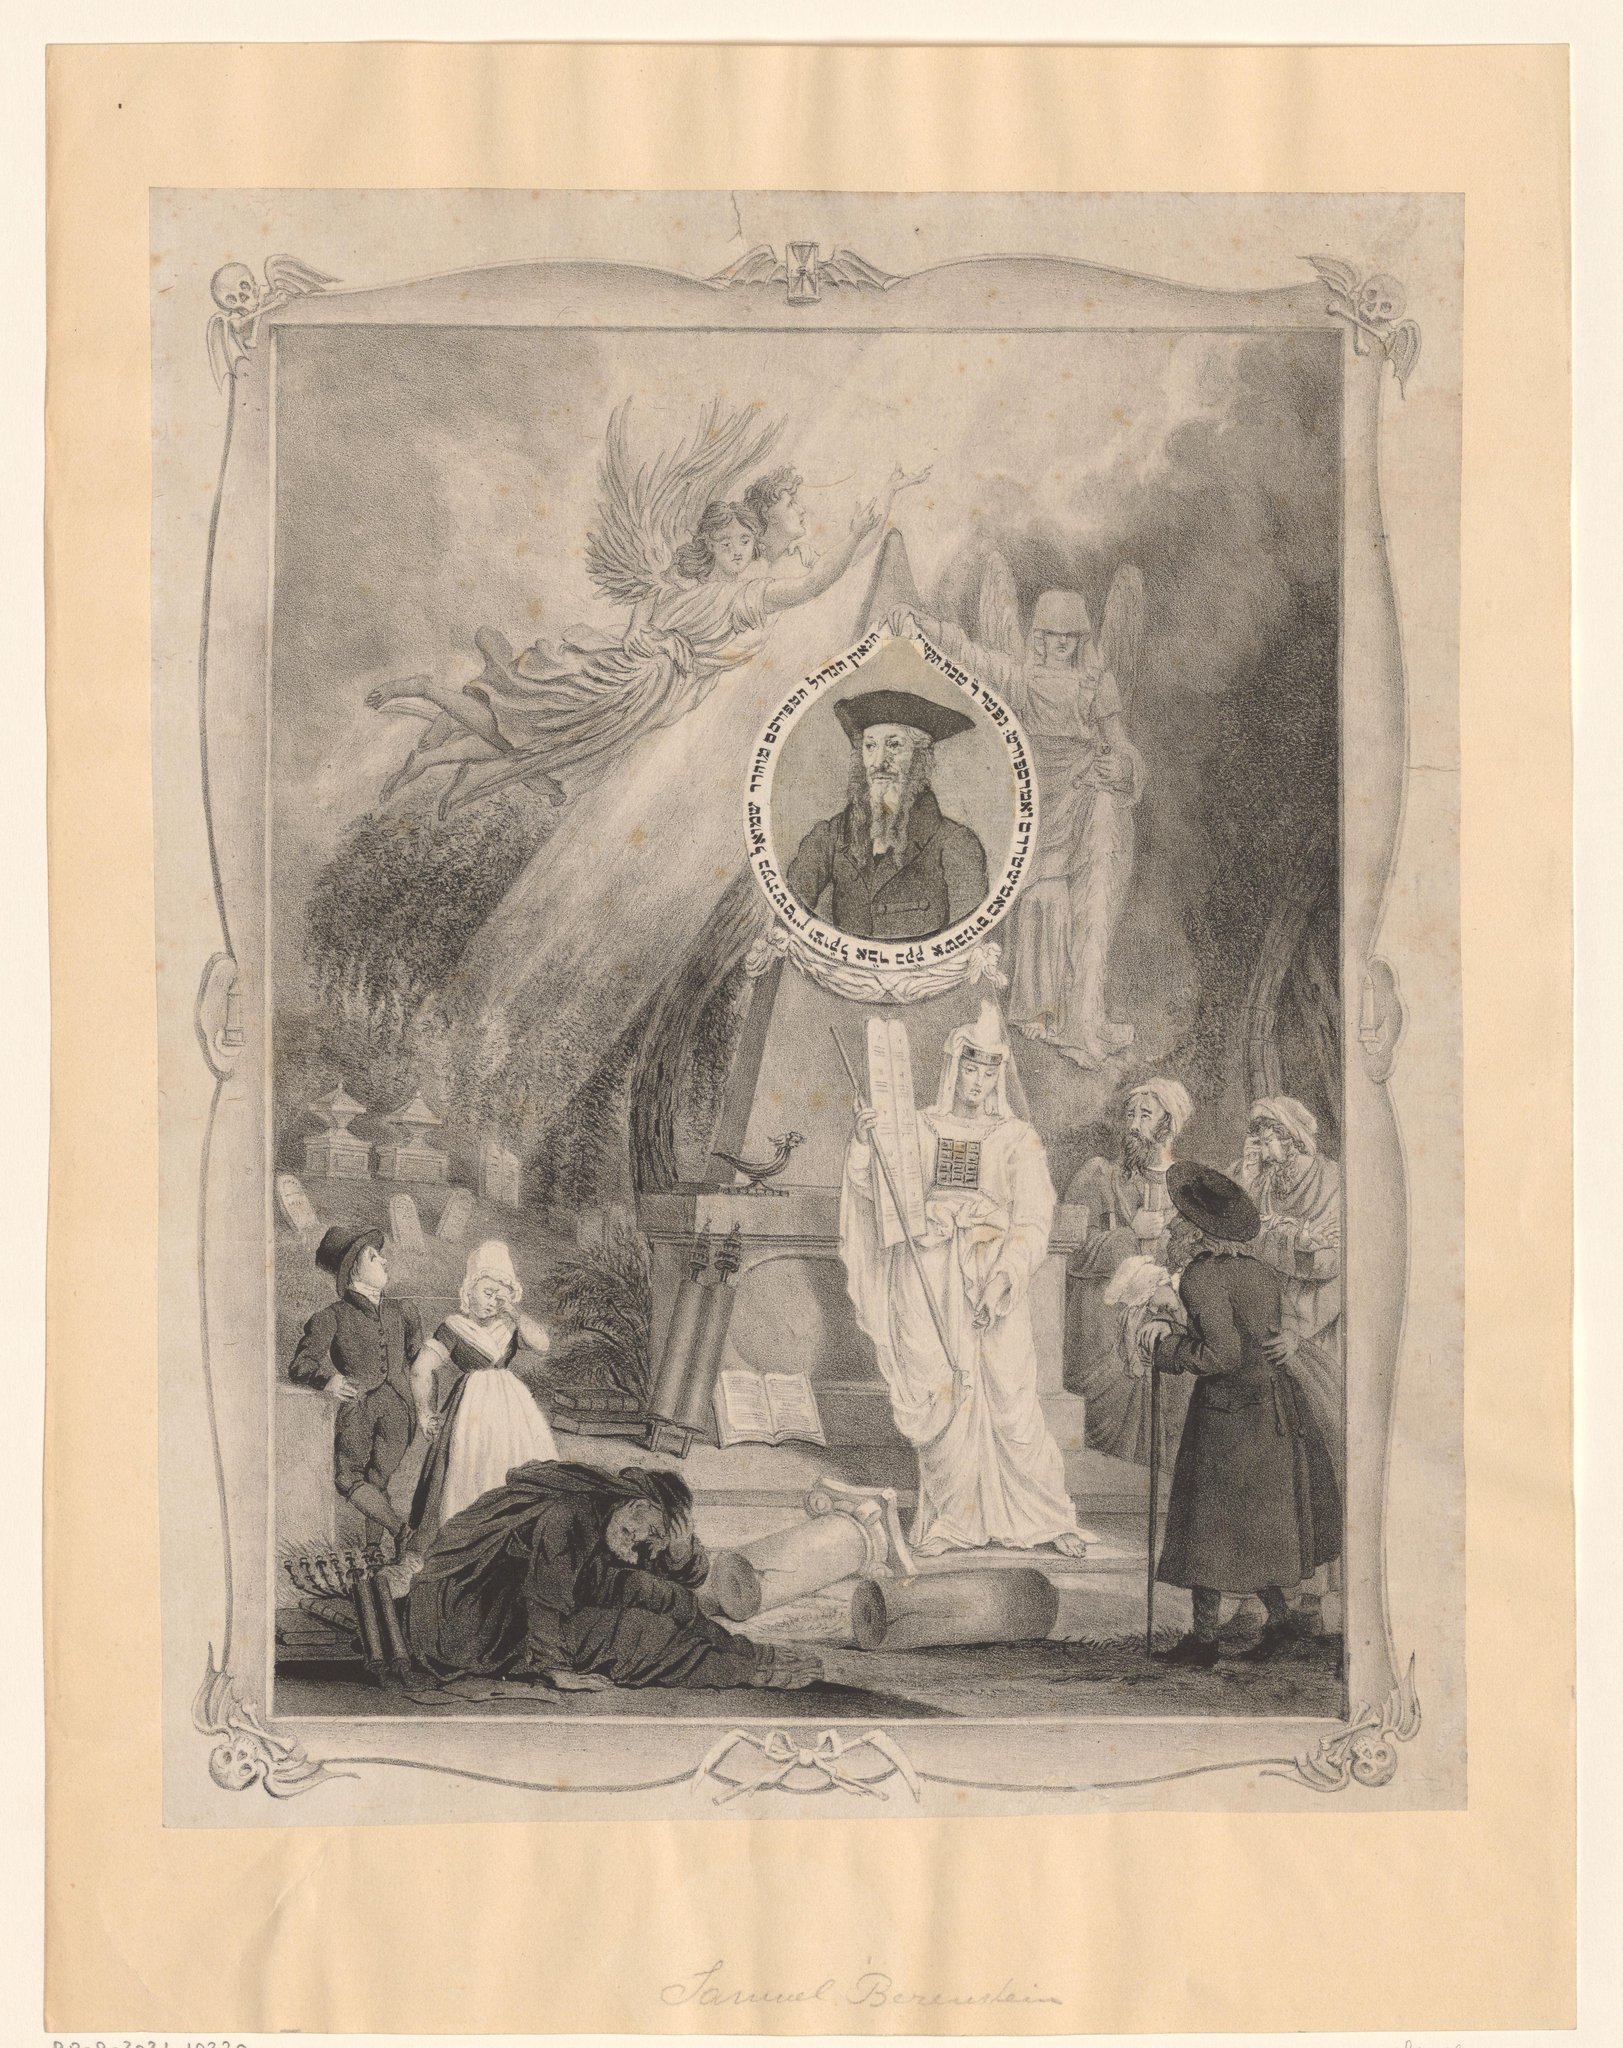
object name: print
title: Rouwprent bij het overlijden van rabbijn Samuel Berenstein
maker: morris jacob dessaur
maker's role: print maker, printer, publisher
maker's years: 1799-1876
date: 1838-1840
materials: paper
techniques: lithograph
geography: amsterdam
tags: 'synagoga', synagogue, i.e. jewish religion personified (or symbolized), historical persons, churchyard, cemetery, grave-building, monumental tomb, death and burial ~ jewish customs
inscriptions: collector's mark: Lugt 2228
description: Rouwprent bij het overlijden van Amsterdamse rabbijn Samuel Berisch Berenstein, overleden op 21 december 1838. Allegorisch grafmonument met daarop een portret van de rabbijn, waaroverheen een soortgelijk portret is geplakt, met aan de bovenkant een scharniertje zodat het omhoog gevouwen kan worden. In de wolken twee engelen. Voor het graf de personificatie van het Joodse geloof (Synagoga) met de wetstafelen en links op de grond een rouwende schriftgeleerde.